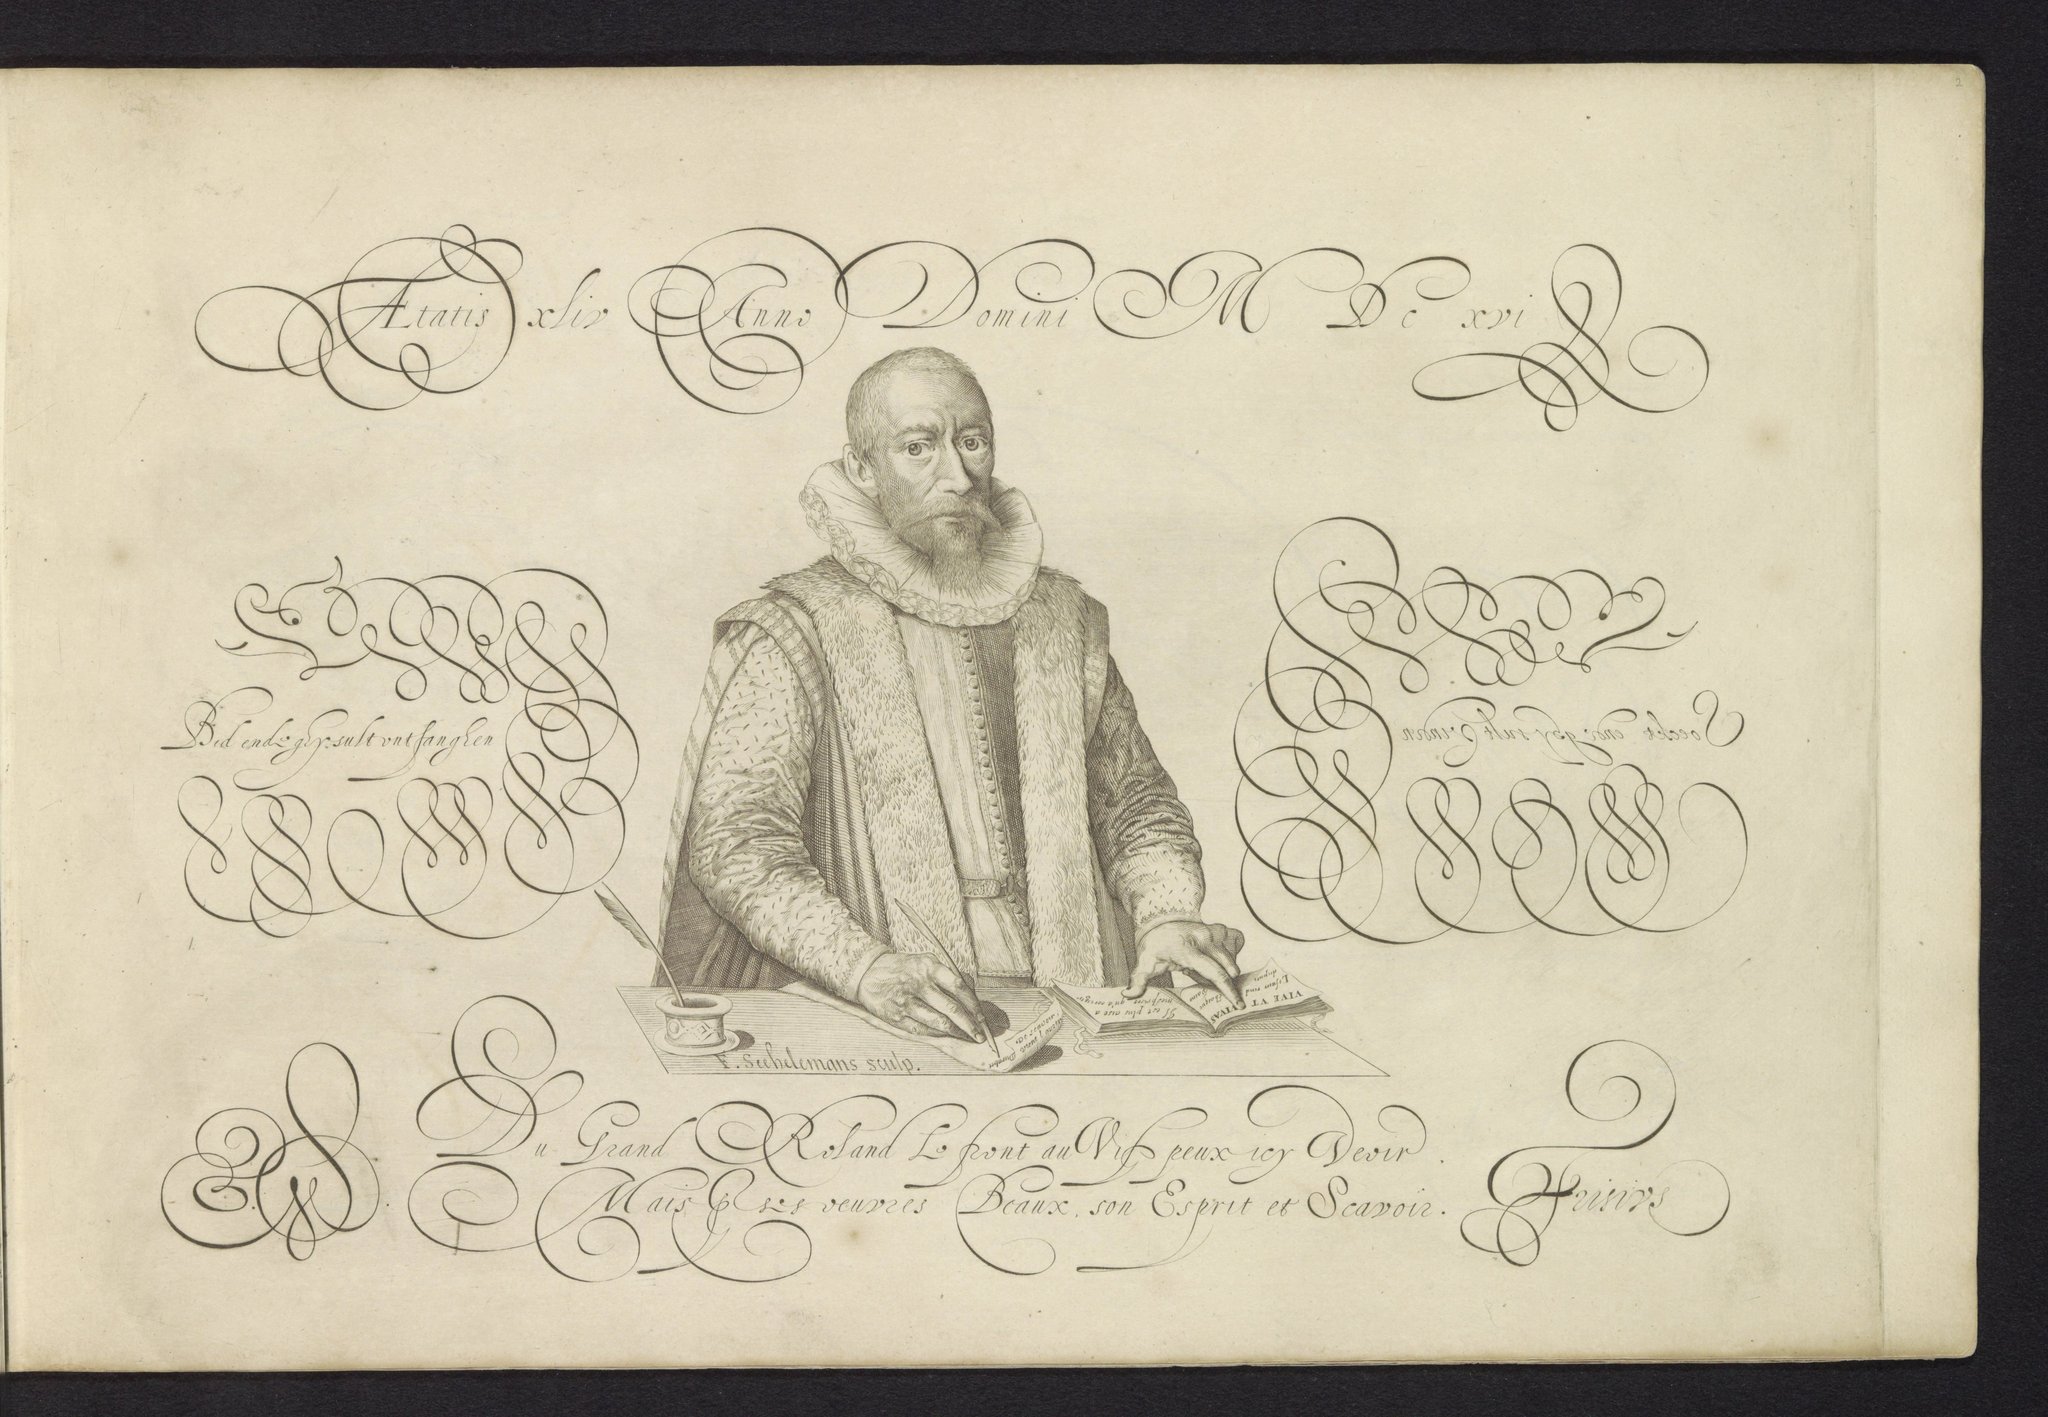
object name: ornament print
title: Portret van David Roelands, op 44-jarige leeftijd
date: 1616-1617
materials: paper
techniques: engraving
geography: flushing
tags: calligraphy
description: Portret van David Roelands, schoolmeester en kalligraaf te Vlissingen, schrijvend. Links van het portret staat in kalligrafie: Bid en ghy sult ontfanghen. Rechts staat omgekeerd: Soeckt en ghy sult vinden. De prent maakt deel uit van een album getiteld: Prijs boek van Jan Malnoe.